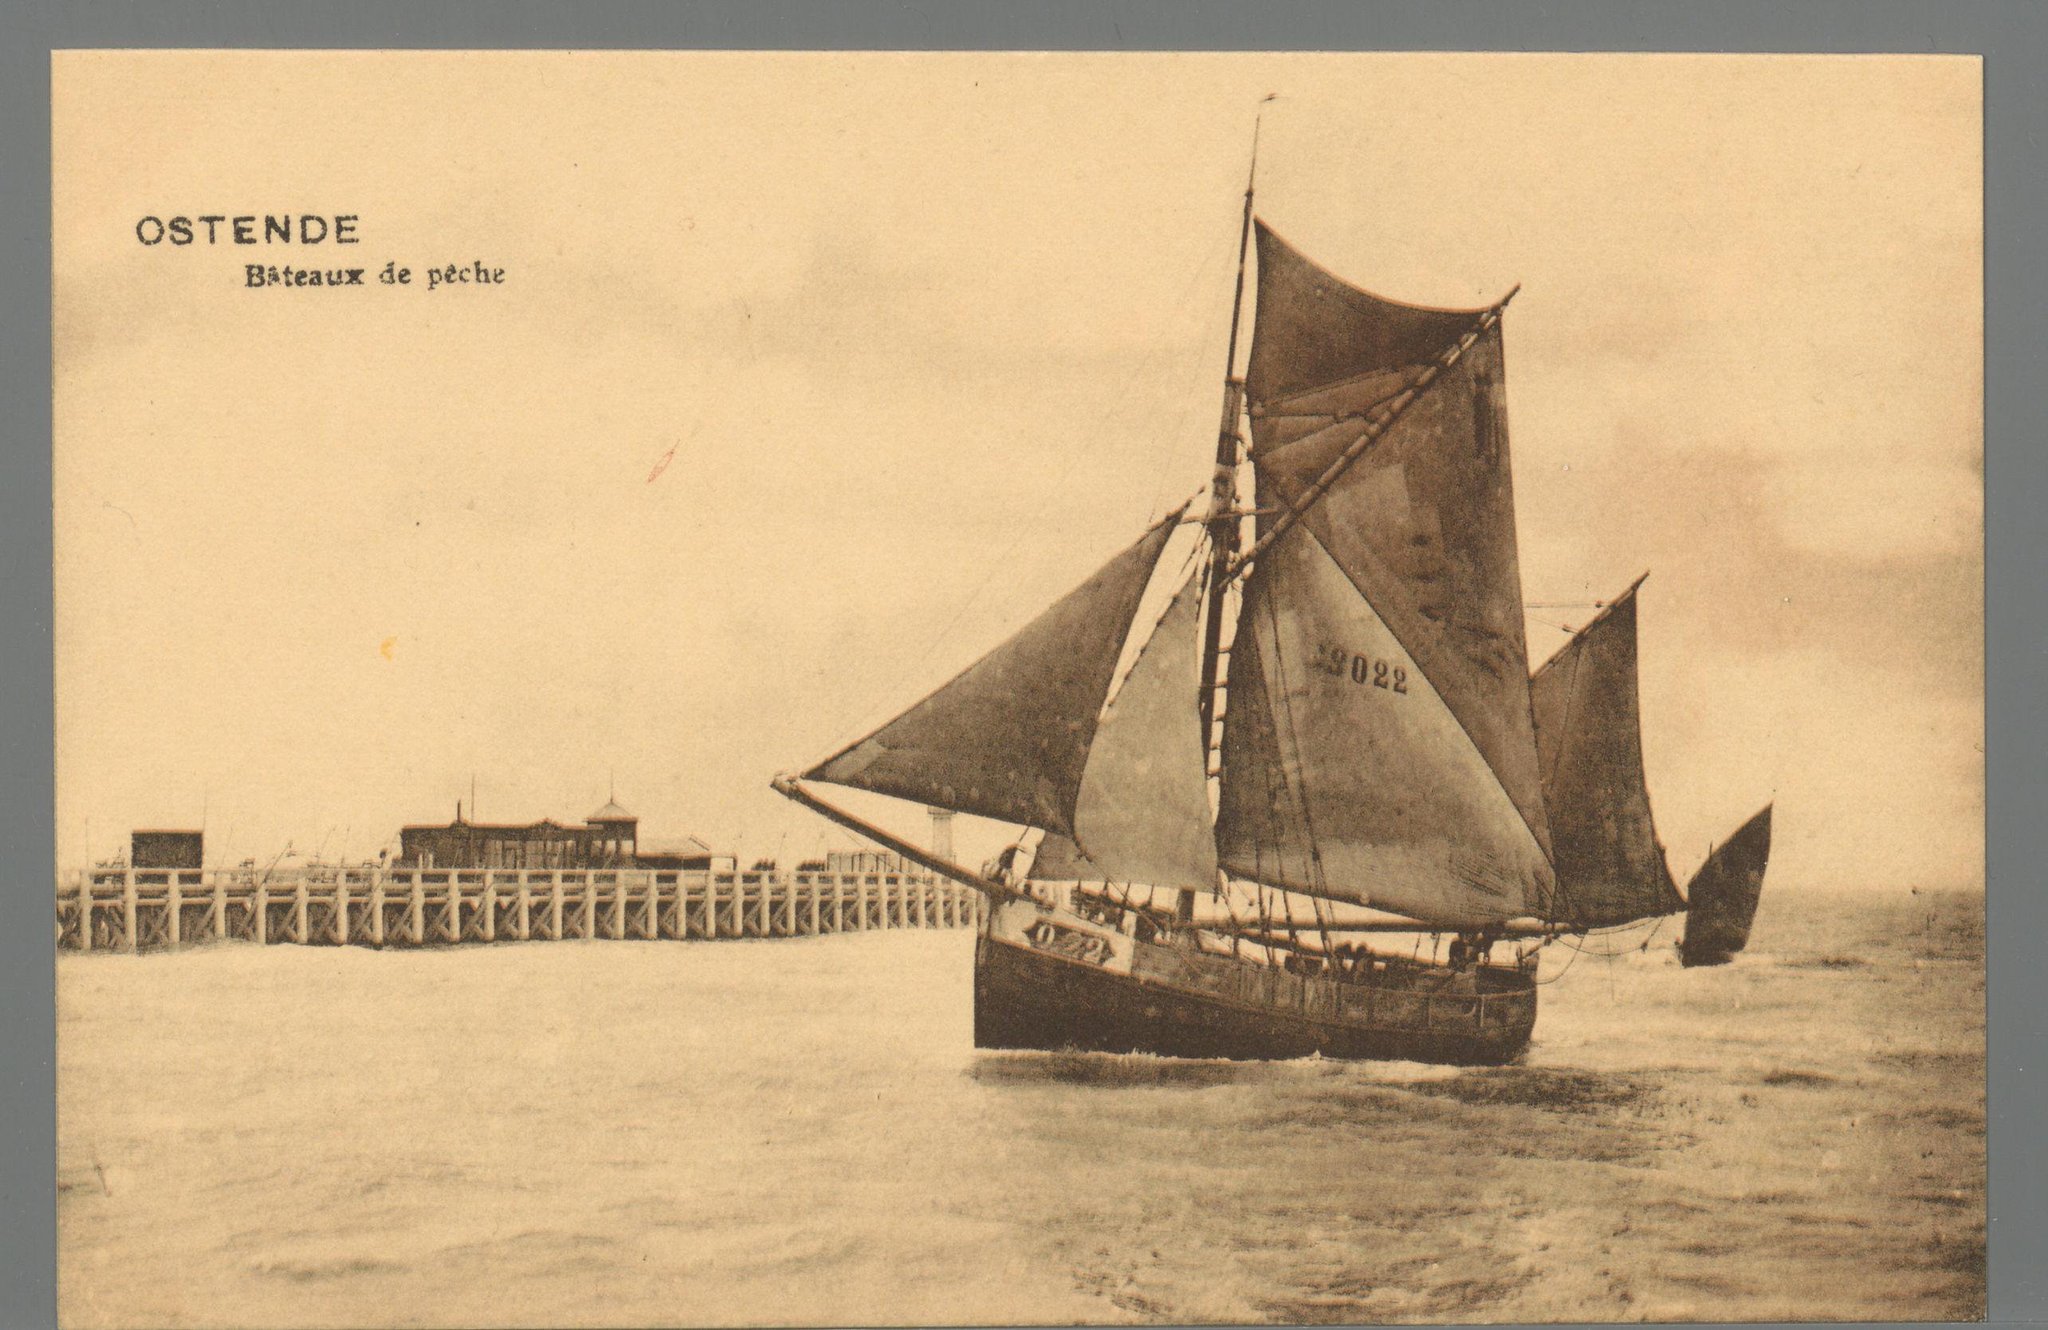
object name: ansichtkaart, prentbriefkaart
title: Ostende. Bâteaux de pêche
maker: Anonymous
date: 1906-1930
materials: cardboard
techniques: photograph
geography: oostende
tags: sailing-ship, sailing-boat, sea and coastal fishery, sea